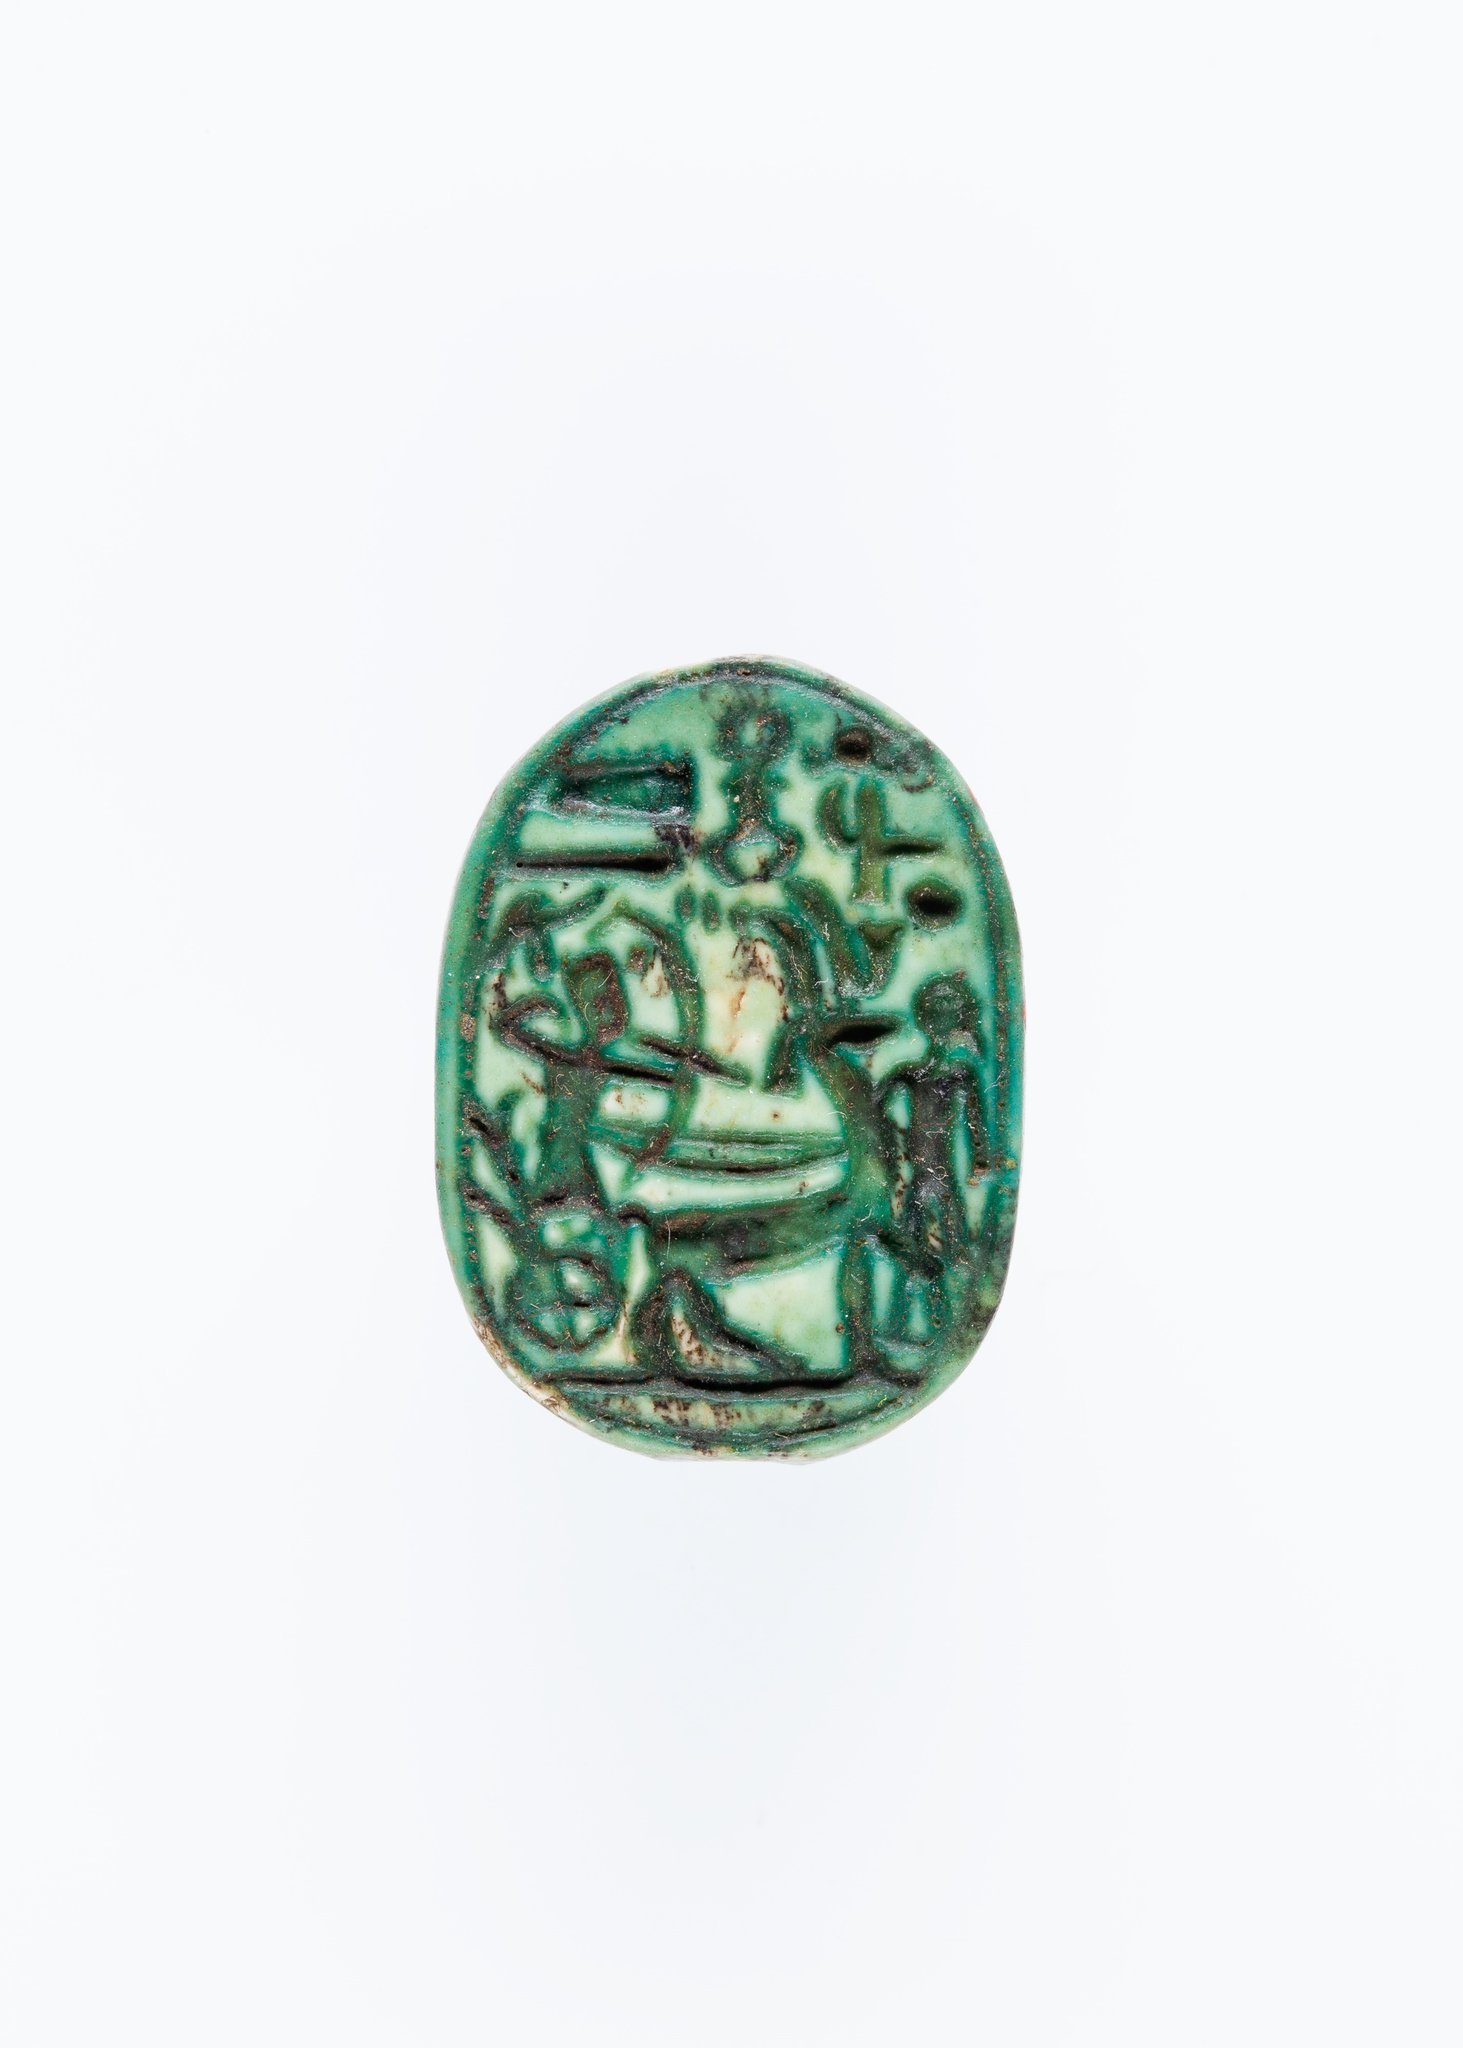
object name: scarab, seti ii in his chariot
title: Scarab Depicting Seti II In His Chariot Shooting a Bow and Arrow.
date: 1200-1194 BCE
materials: stone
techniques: glazing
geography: egypt